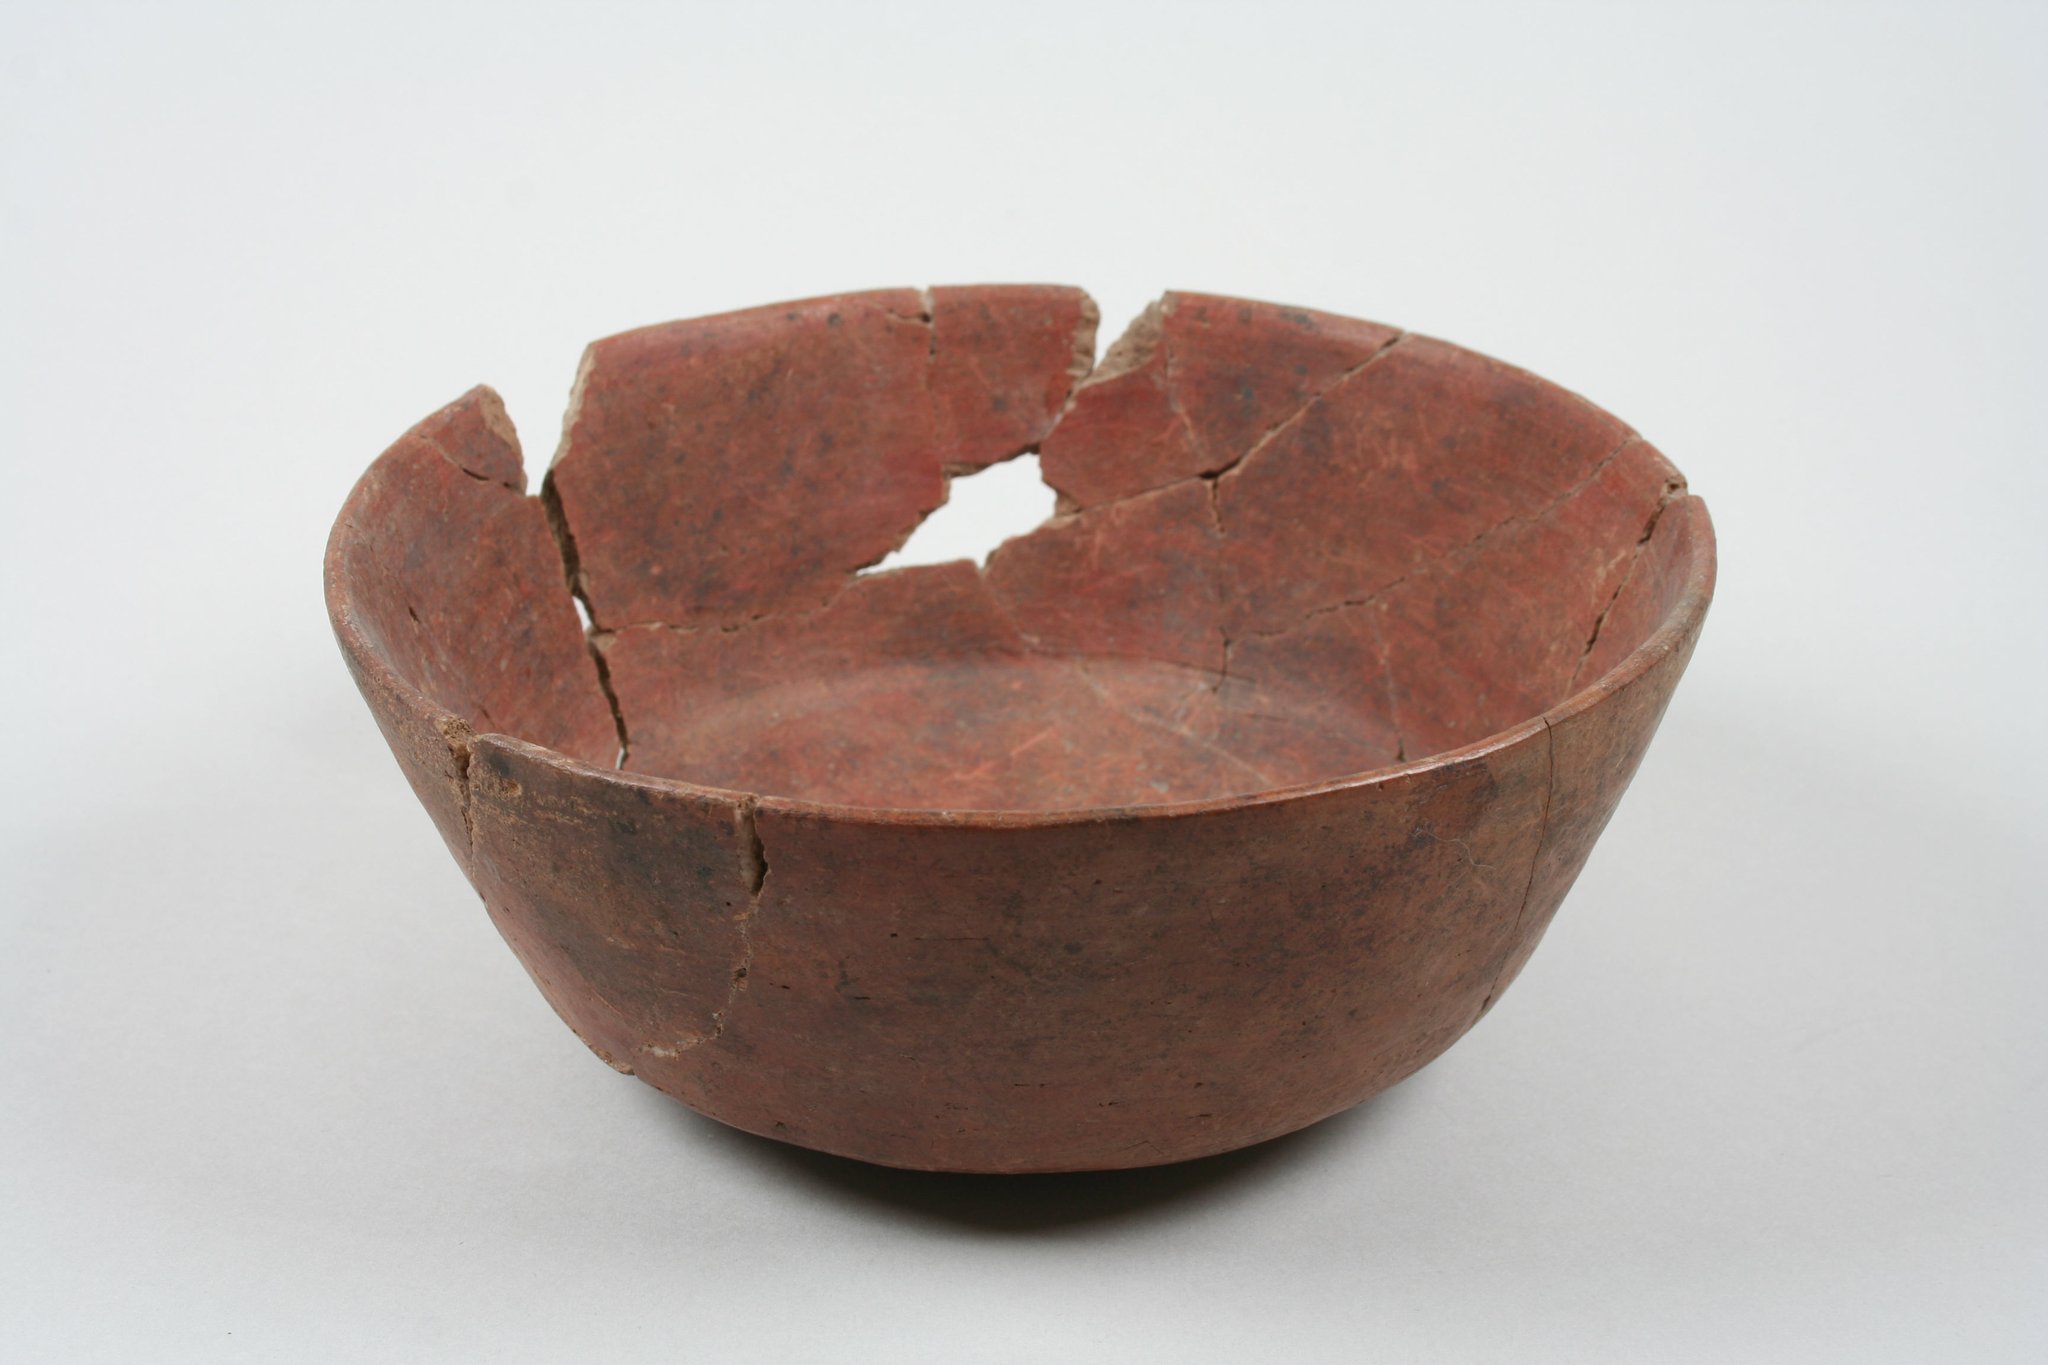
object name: bowl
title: Undecorated painted bowl with straight sides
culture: paracas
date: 600-201 BCE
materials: ceramic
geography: peru